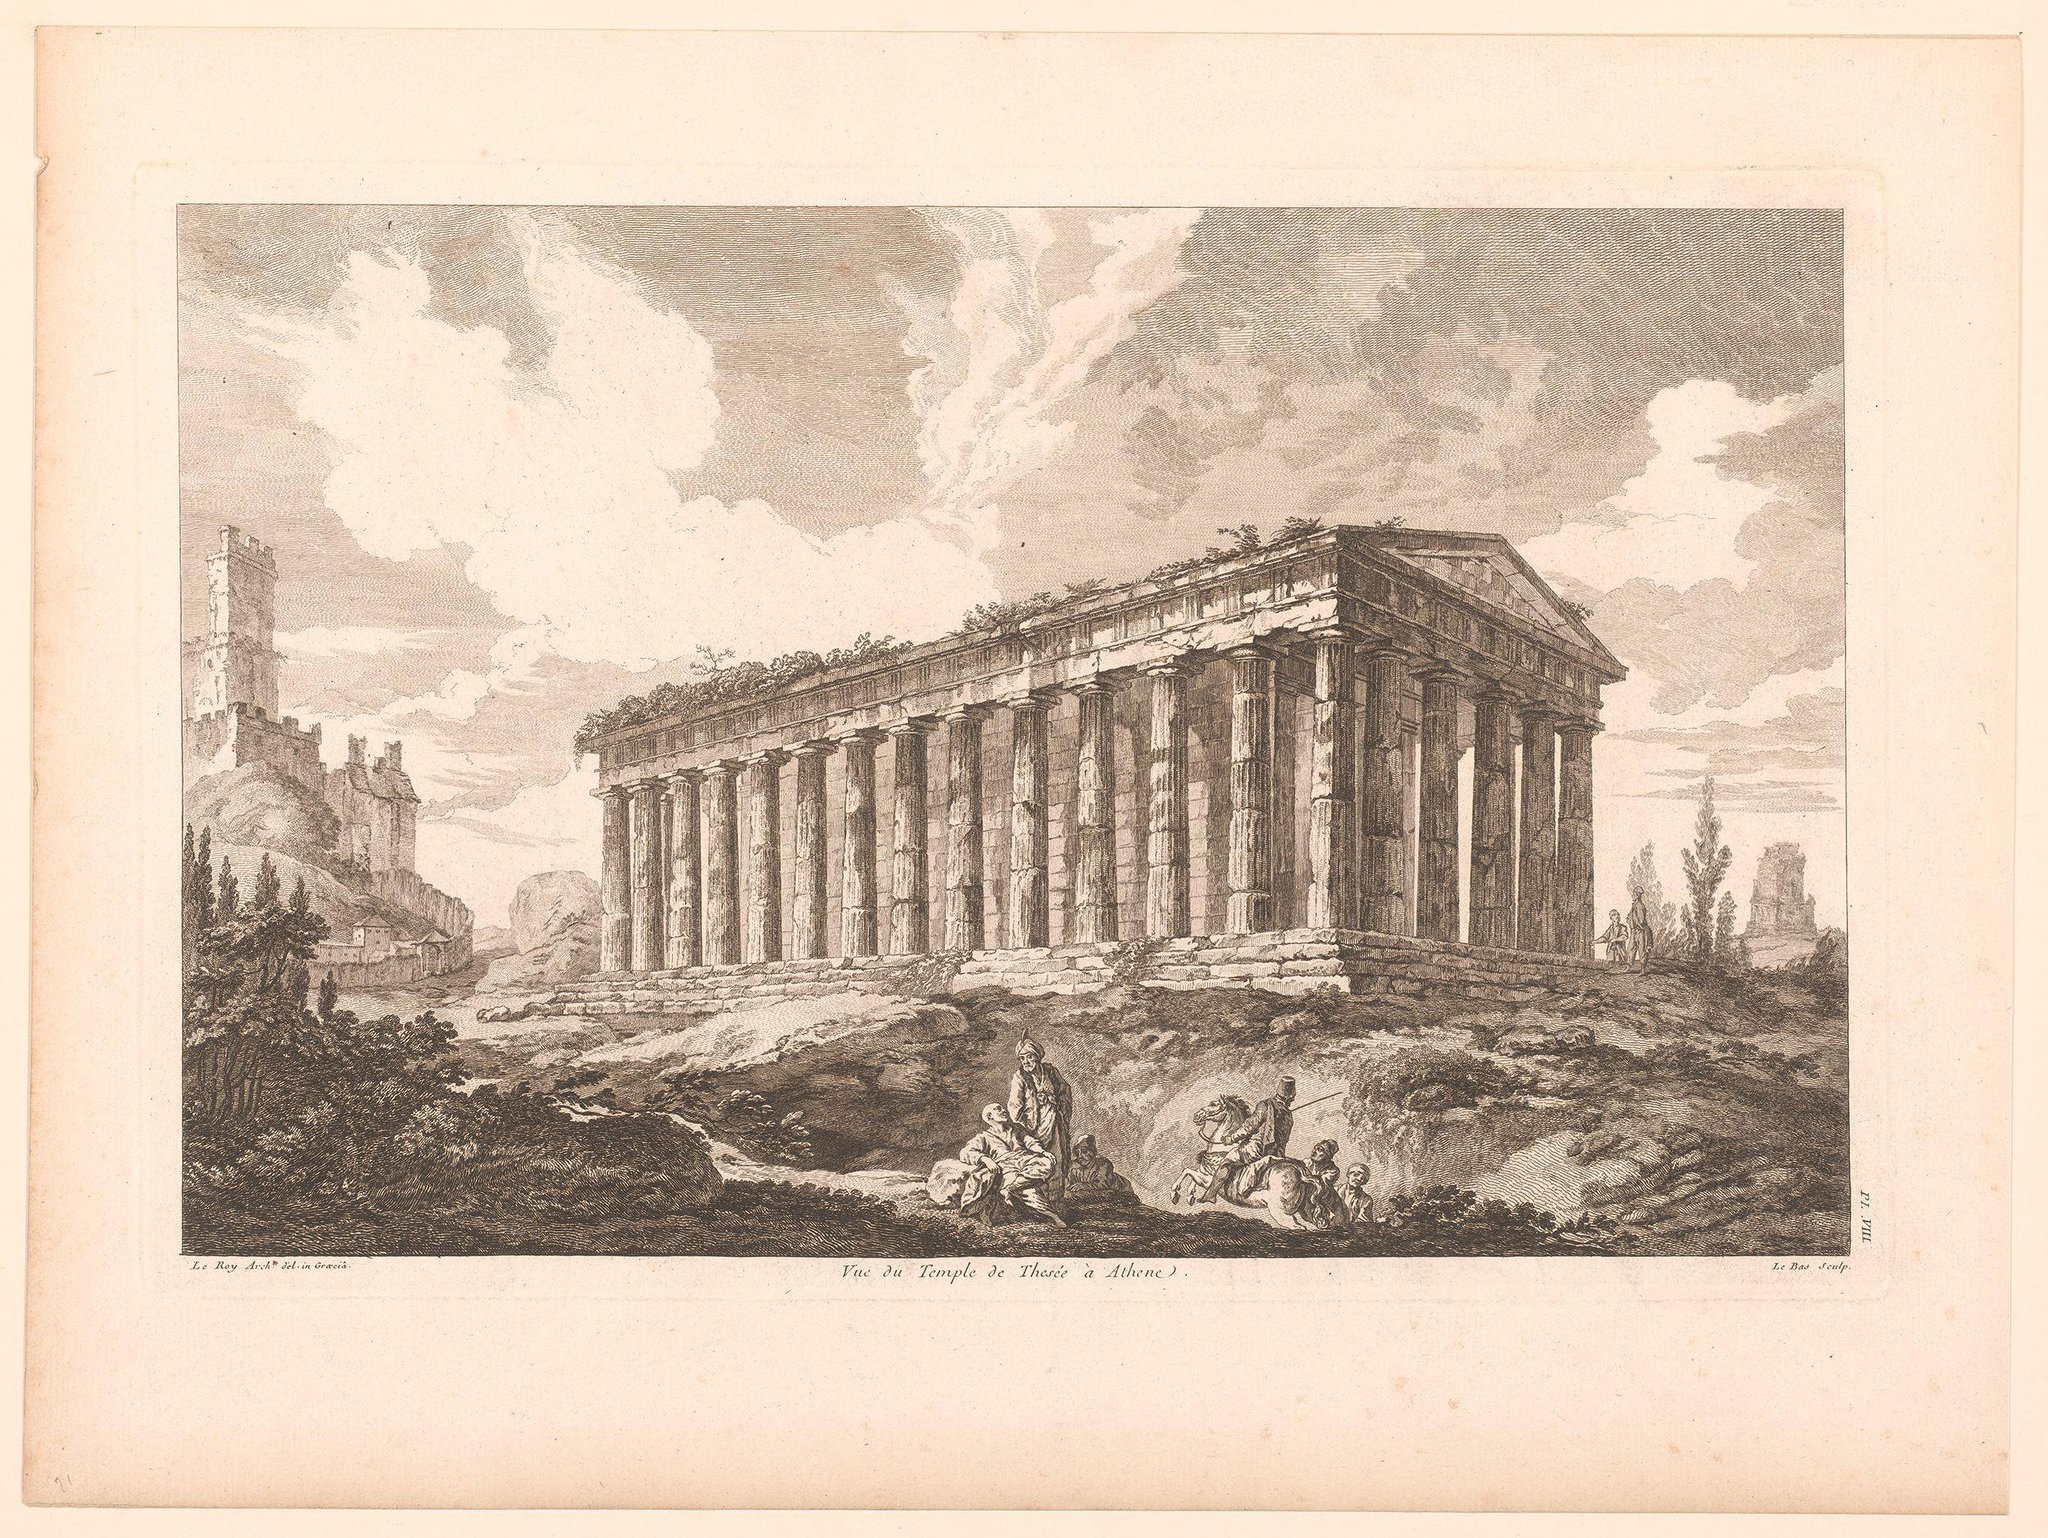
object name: book illustration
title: Gezicht op de tempel van Hephaistos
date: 1758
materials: paper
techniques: etching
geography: greece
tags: ruin of a building ~ architecture, landscape with ruins, temple, shrine ~ greek religion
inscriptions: collector's mark: Lugt 2228, collector's mark: Lugt 2760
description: Prent uit: Le Roy, Julien. Ruines des plus beaux monuments de la Grêce. Parijs: Guérin & de La Tour, 1758. Dit betreft plaat VIII.